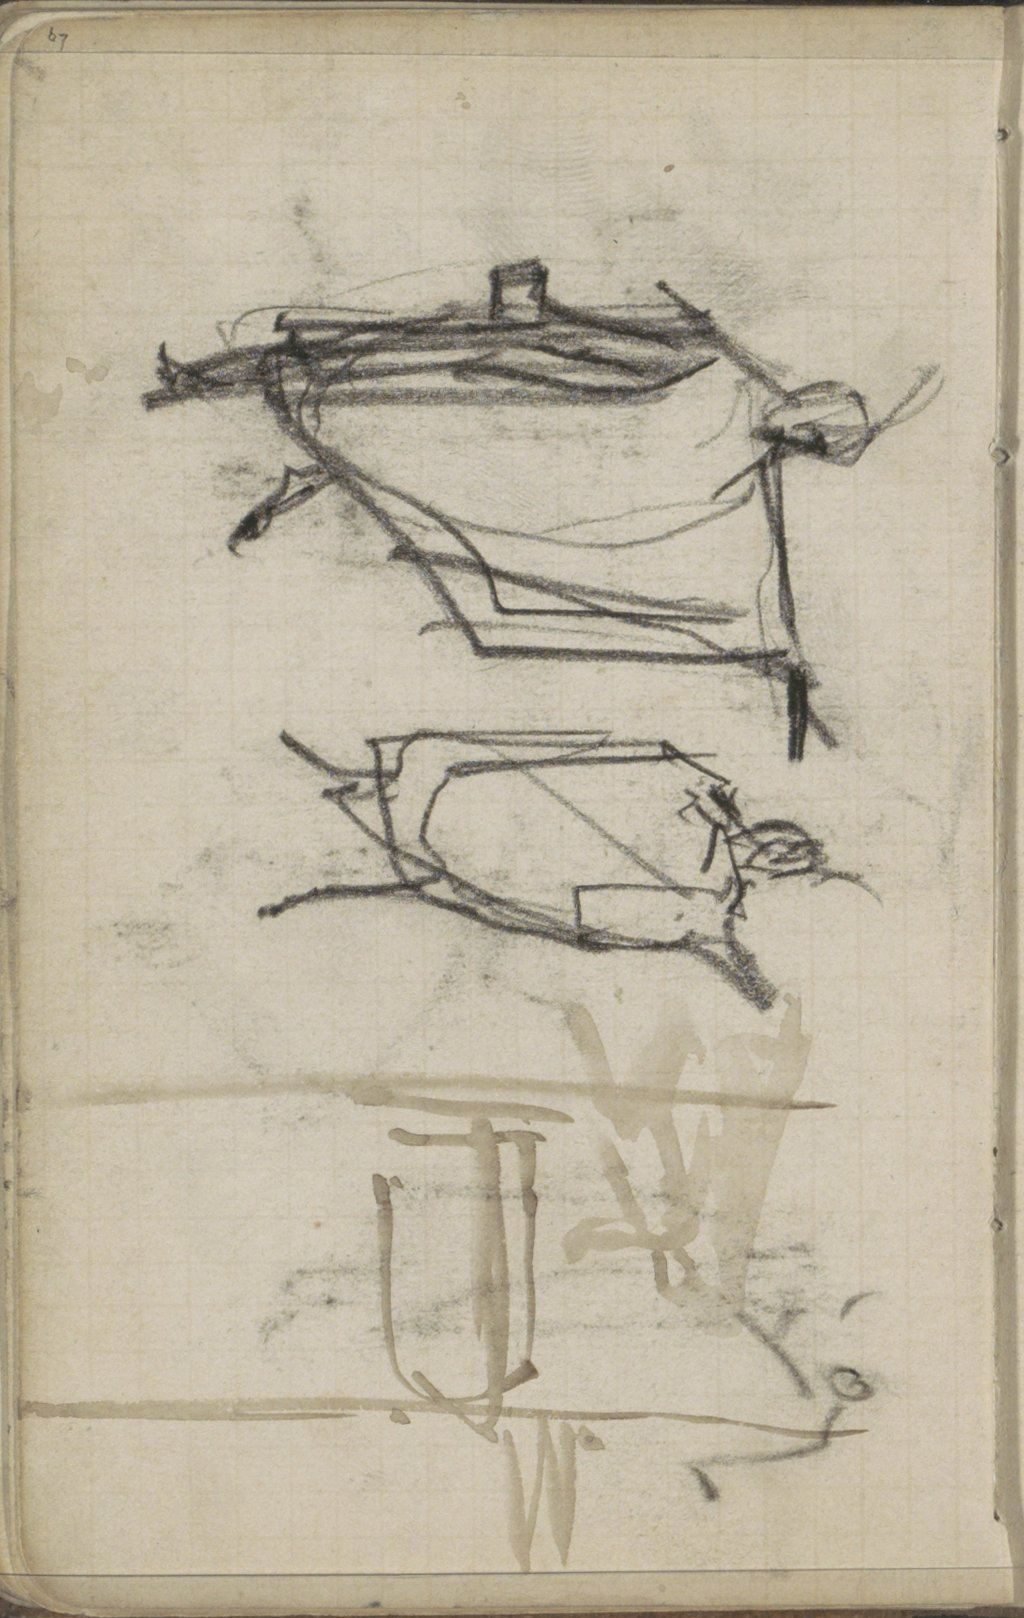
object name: sketchbook leaf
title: Figuren in toga's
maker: marius bauer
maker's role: draughtsman, print maker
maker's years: 1867-1932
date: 1879-1885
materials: chalk, watercolor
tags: adult man, historical costume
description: Tevens een studie van een figuur bij een portaal. Mogelijk verbeeldt de schets een scène uit een theaterstuk. Pagina 67 uit een schetsboek met 58 bladen.